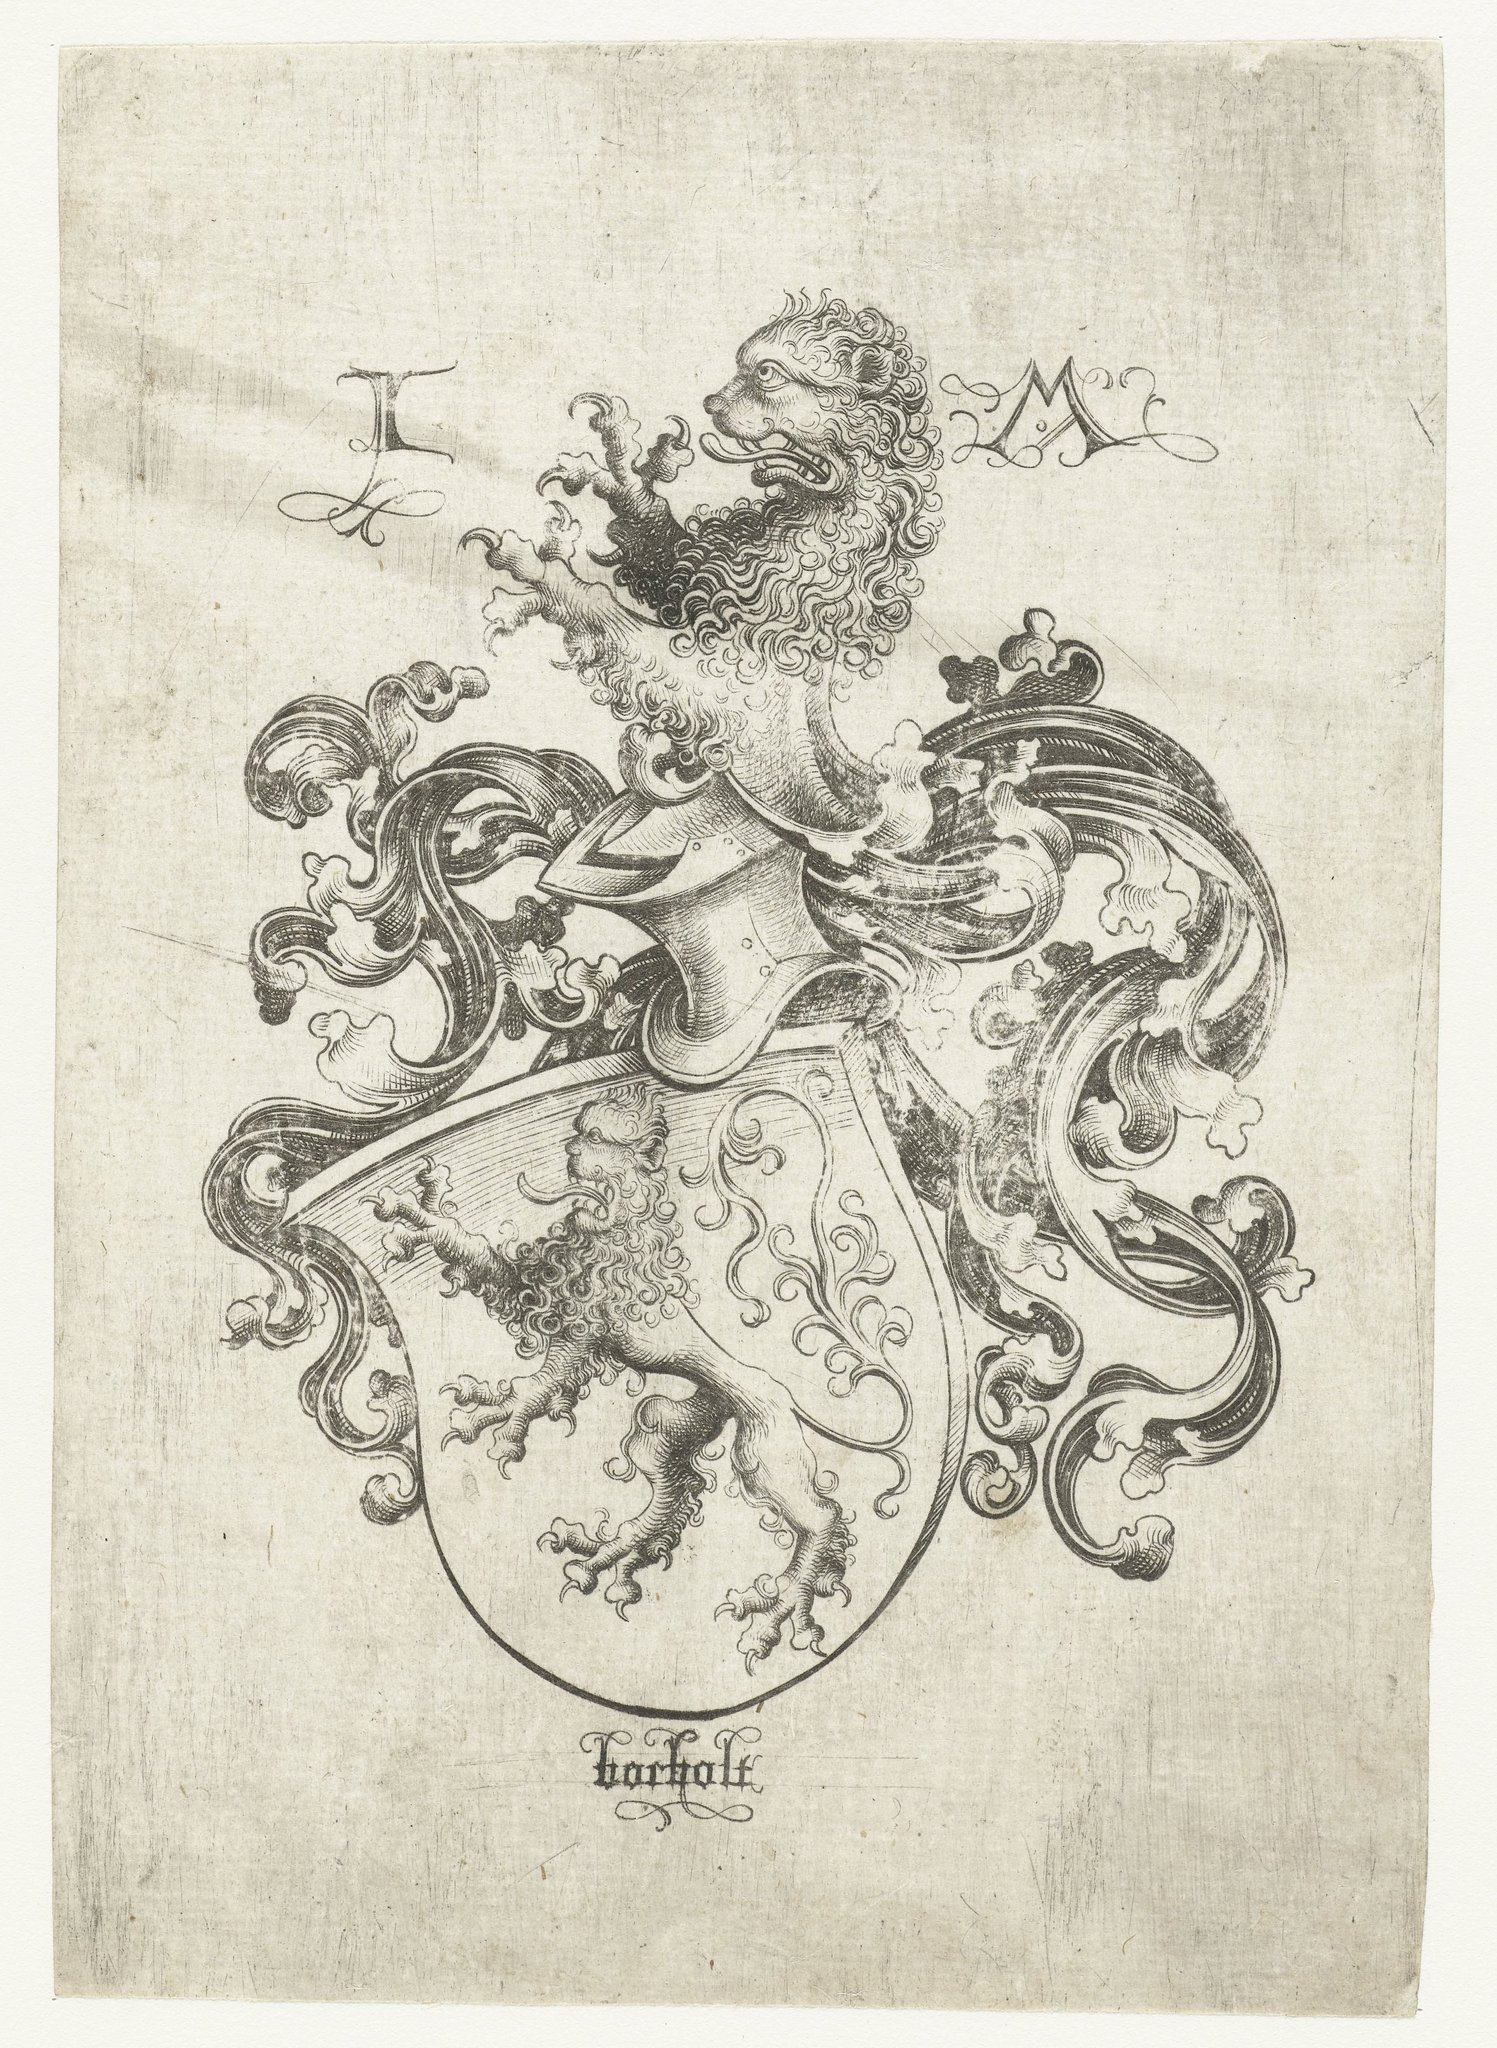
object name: print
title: Wapenschild met leeuw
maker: israhel van meckenem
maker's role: print maker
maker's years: 1440-1517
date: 1455-1503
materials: paper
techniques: engraving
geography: bocholt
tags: armorial bearing, heraldry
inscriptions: collector's mark: Lugt 240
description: Wapenschild met een klimmende leeuw erop. Daaromheen bladmotieven en (nog) een leeuw. Onder het schild 'bocholt' in gotische letters.